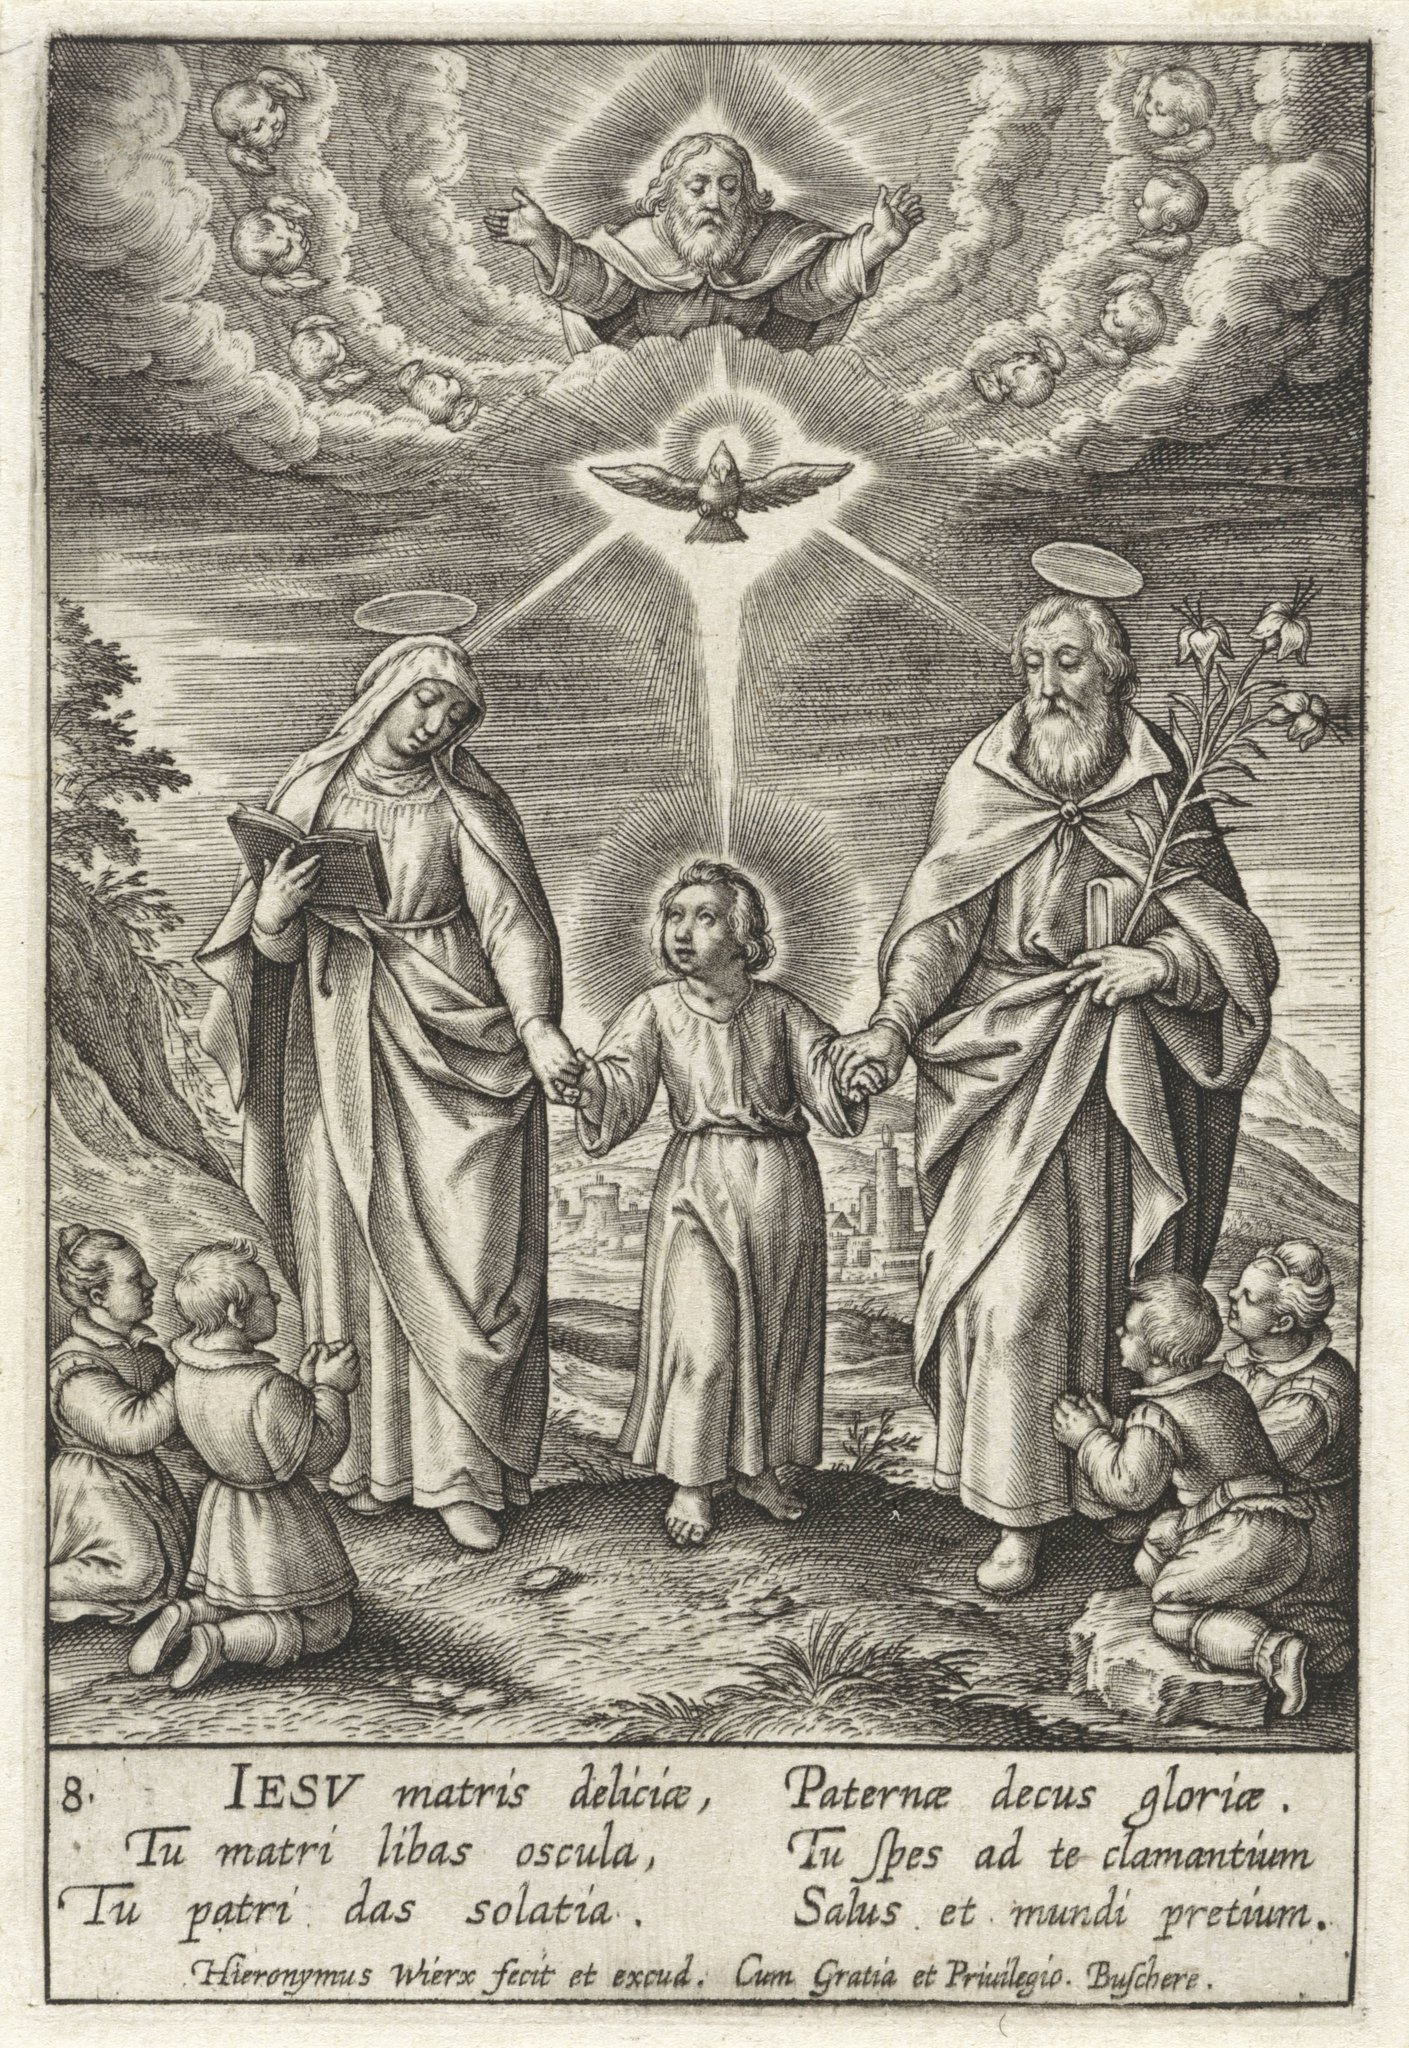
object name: print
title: Aardse en hemelse Drieëenheid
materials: paper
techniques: engraving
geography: antwerp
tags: quinity, the holy trinity, 'trinitas coelestis'; father, son and holy ghost ~ christian religion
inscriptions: collector's mark: Lugt 2228, collector's mark: Lugt 2542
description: Landschap met het Christuskind, te midden van Maria en Jozef. Boven het Kind, de Heilige Geest in de gedaante van een duif en God de Vader, omringd door cherubijnen. Het Christuskind wordt aanbeden door geknielde kinderen. In de marge een zesregelig onderschrift, in twee kolommen, in het Latijn.